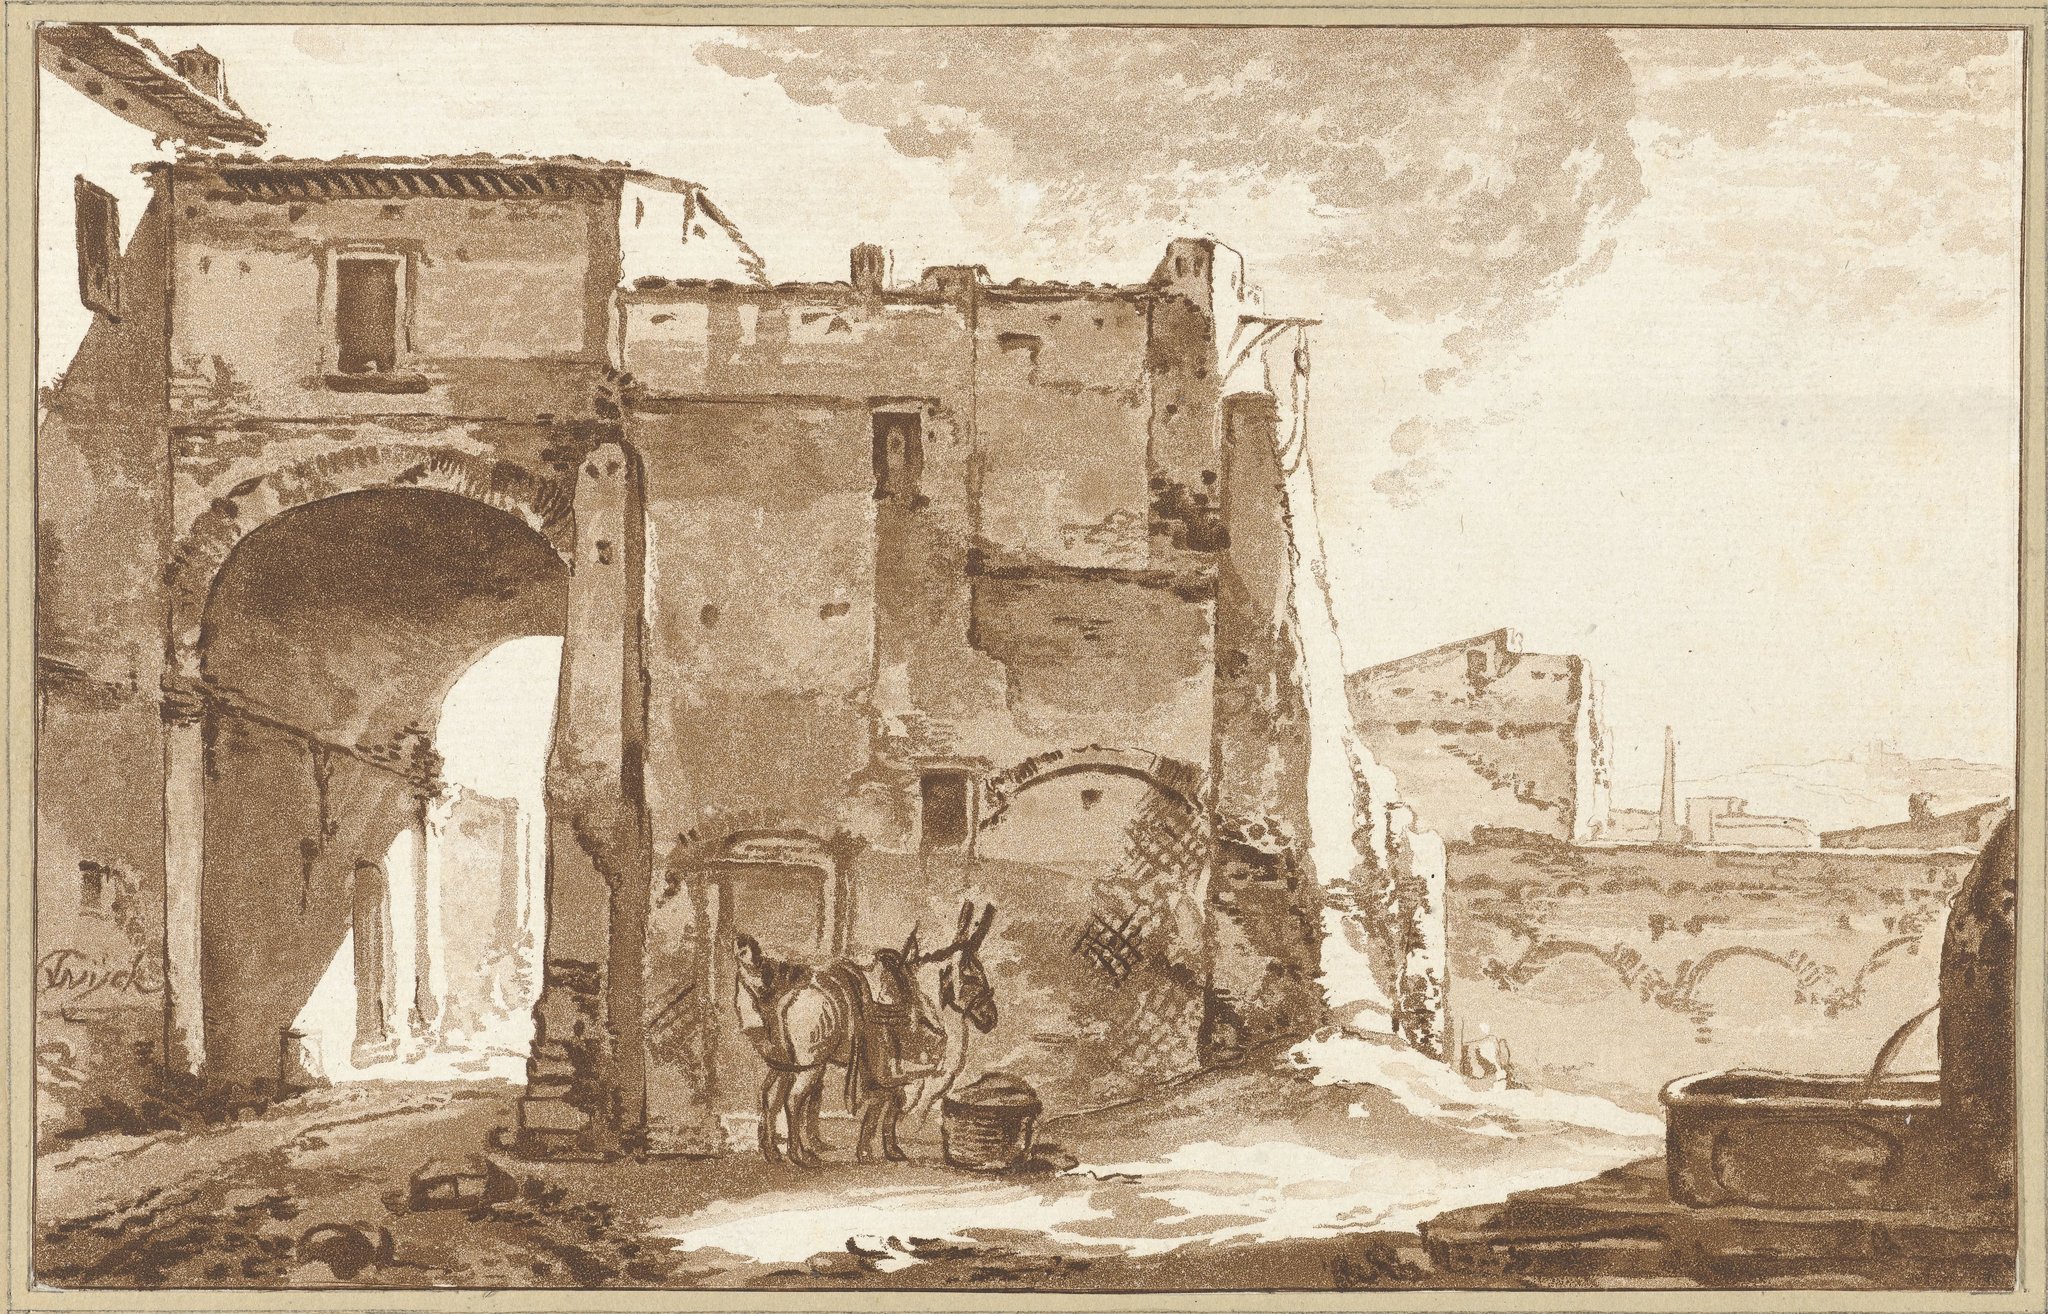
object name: print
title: Poort met reiziger en muildier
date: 1781-1782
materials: paper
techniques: etching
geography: amsterdam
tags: gate, entrance, mule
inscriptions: collector's mark: Lugt 2725, collector's mark: Lugt 12